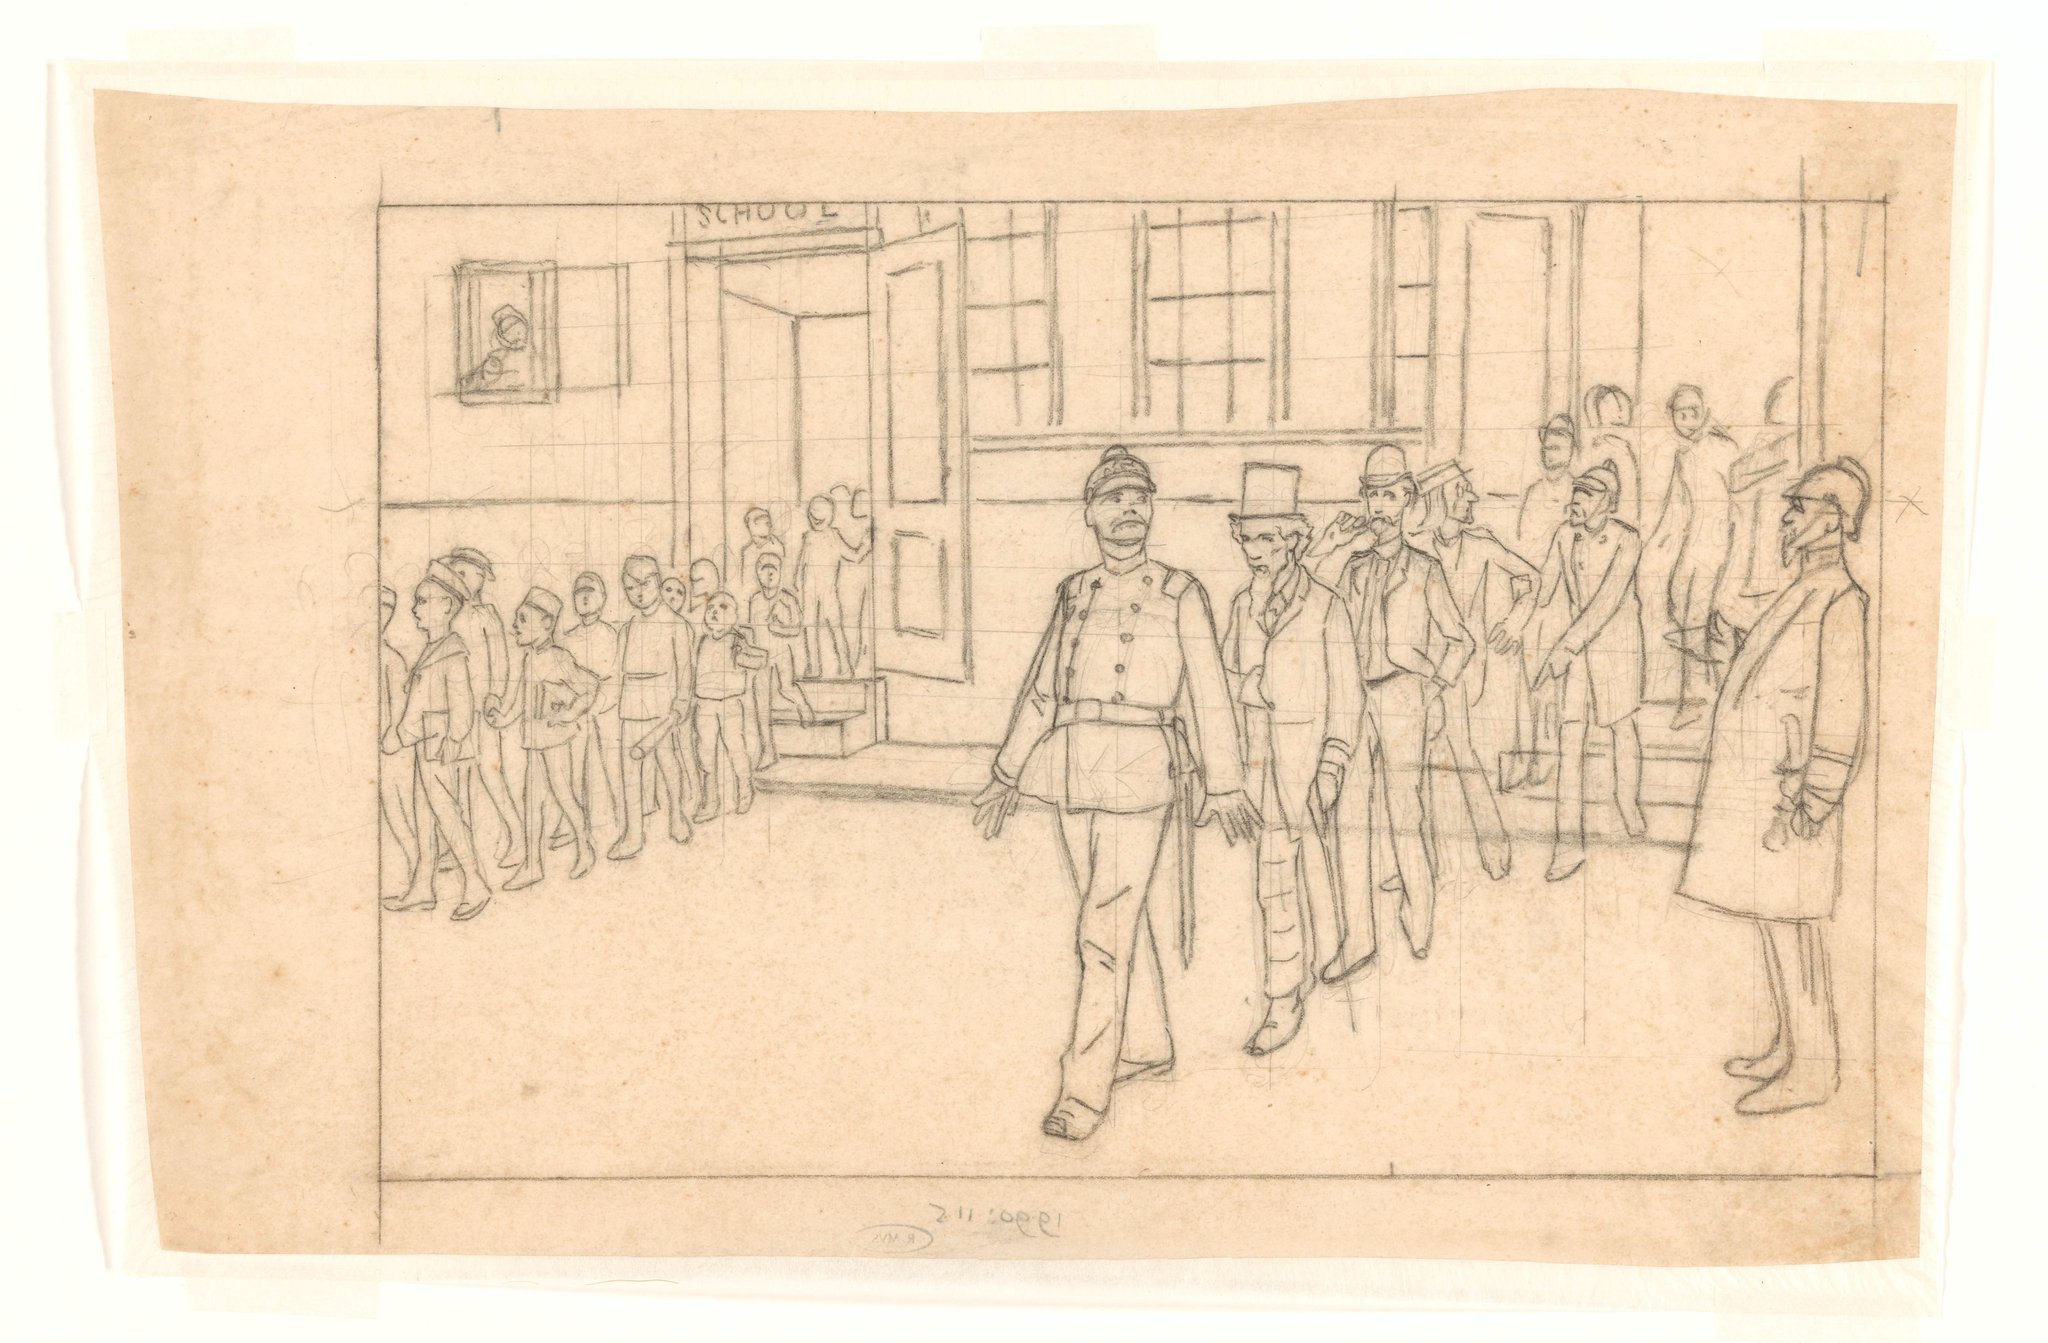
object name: design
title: Ontwerp voor illustratie in De Amsterdammer: Uit een school komen zowel jongens als volwassenen (26 Juli 1896)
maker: johan braakensiek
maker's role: draughtsman, print maker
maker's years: 1858-1940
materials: chalk, pencil, paper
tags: historical events and situations, political caricatures and satires